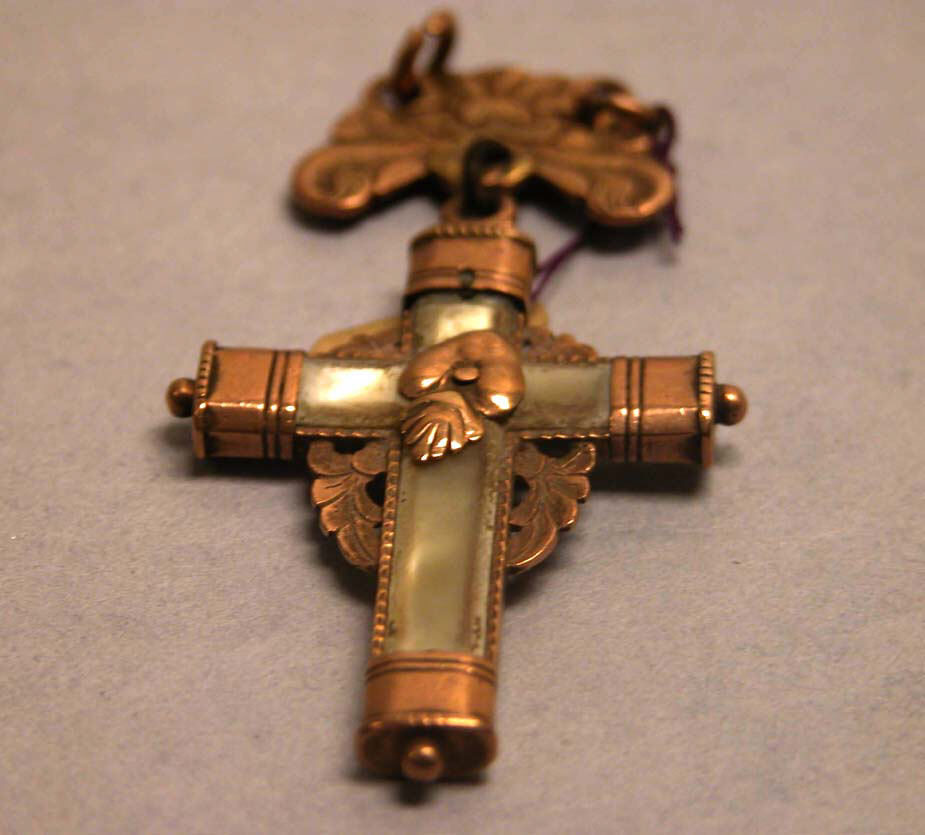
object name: cross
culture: filipino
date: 1601-1900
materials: gold, mother of pearl